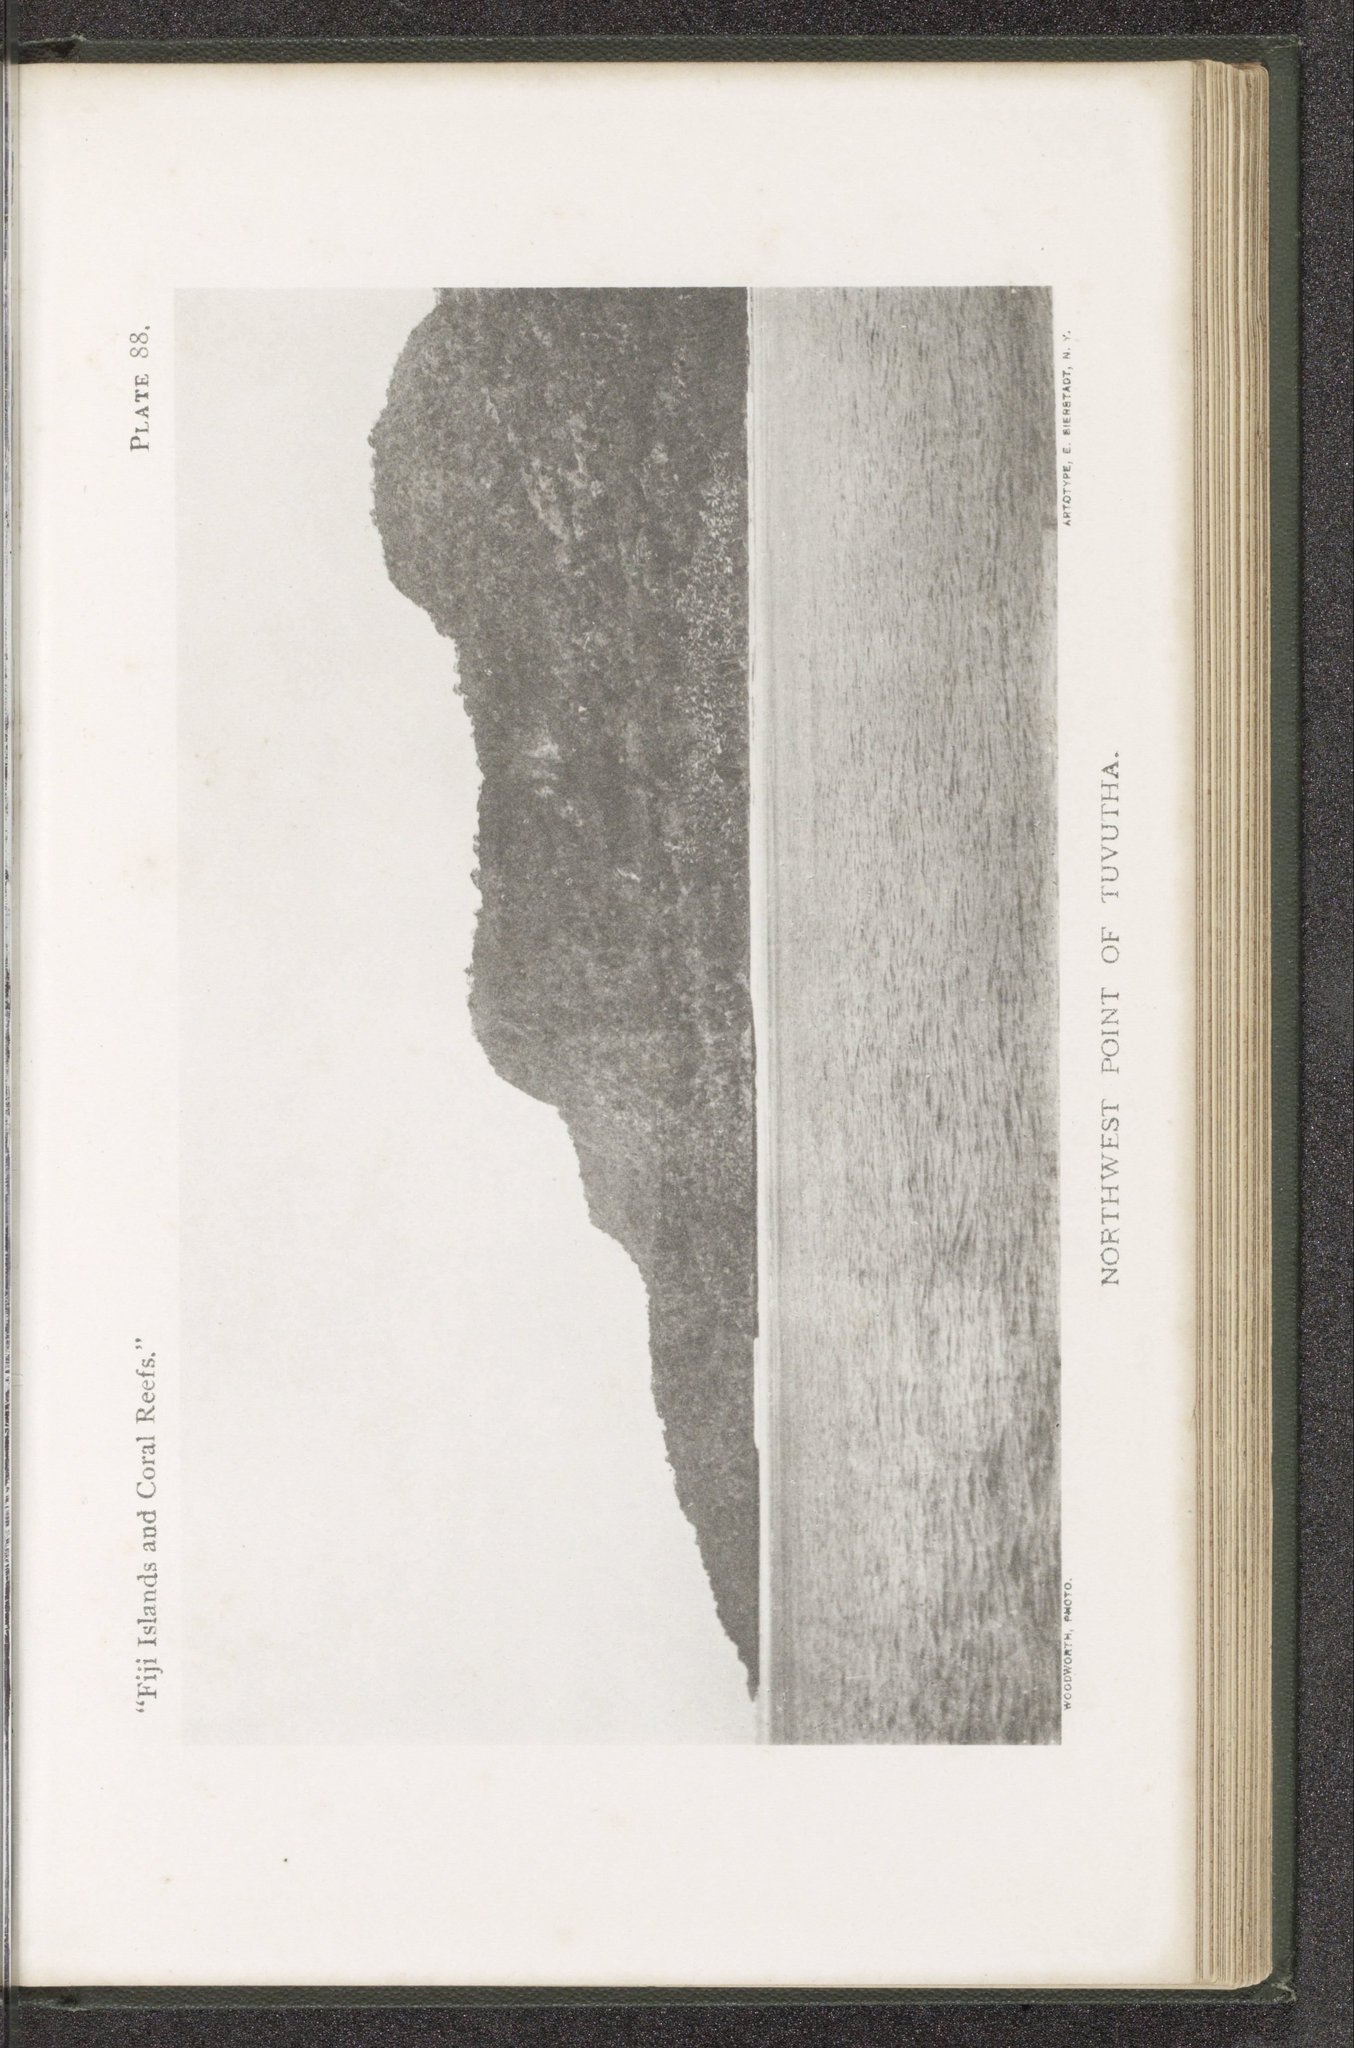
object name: page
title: Gezicht op Tuvuca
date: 1885-1899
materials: paper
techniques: photograph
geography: new york city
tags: island, ocean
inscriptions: number: ‘Plate 88.’, name: ‘Woodworth, Photo.’, name: ‘Artotype, E. Bierstadt, N. Y.’